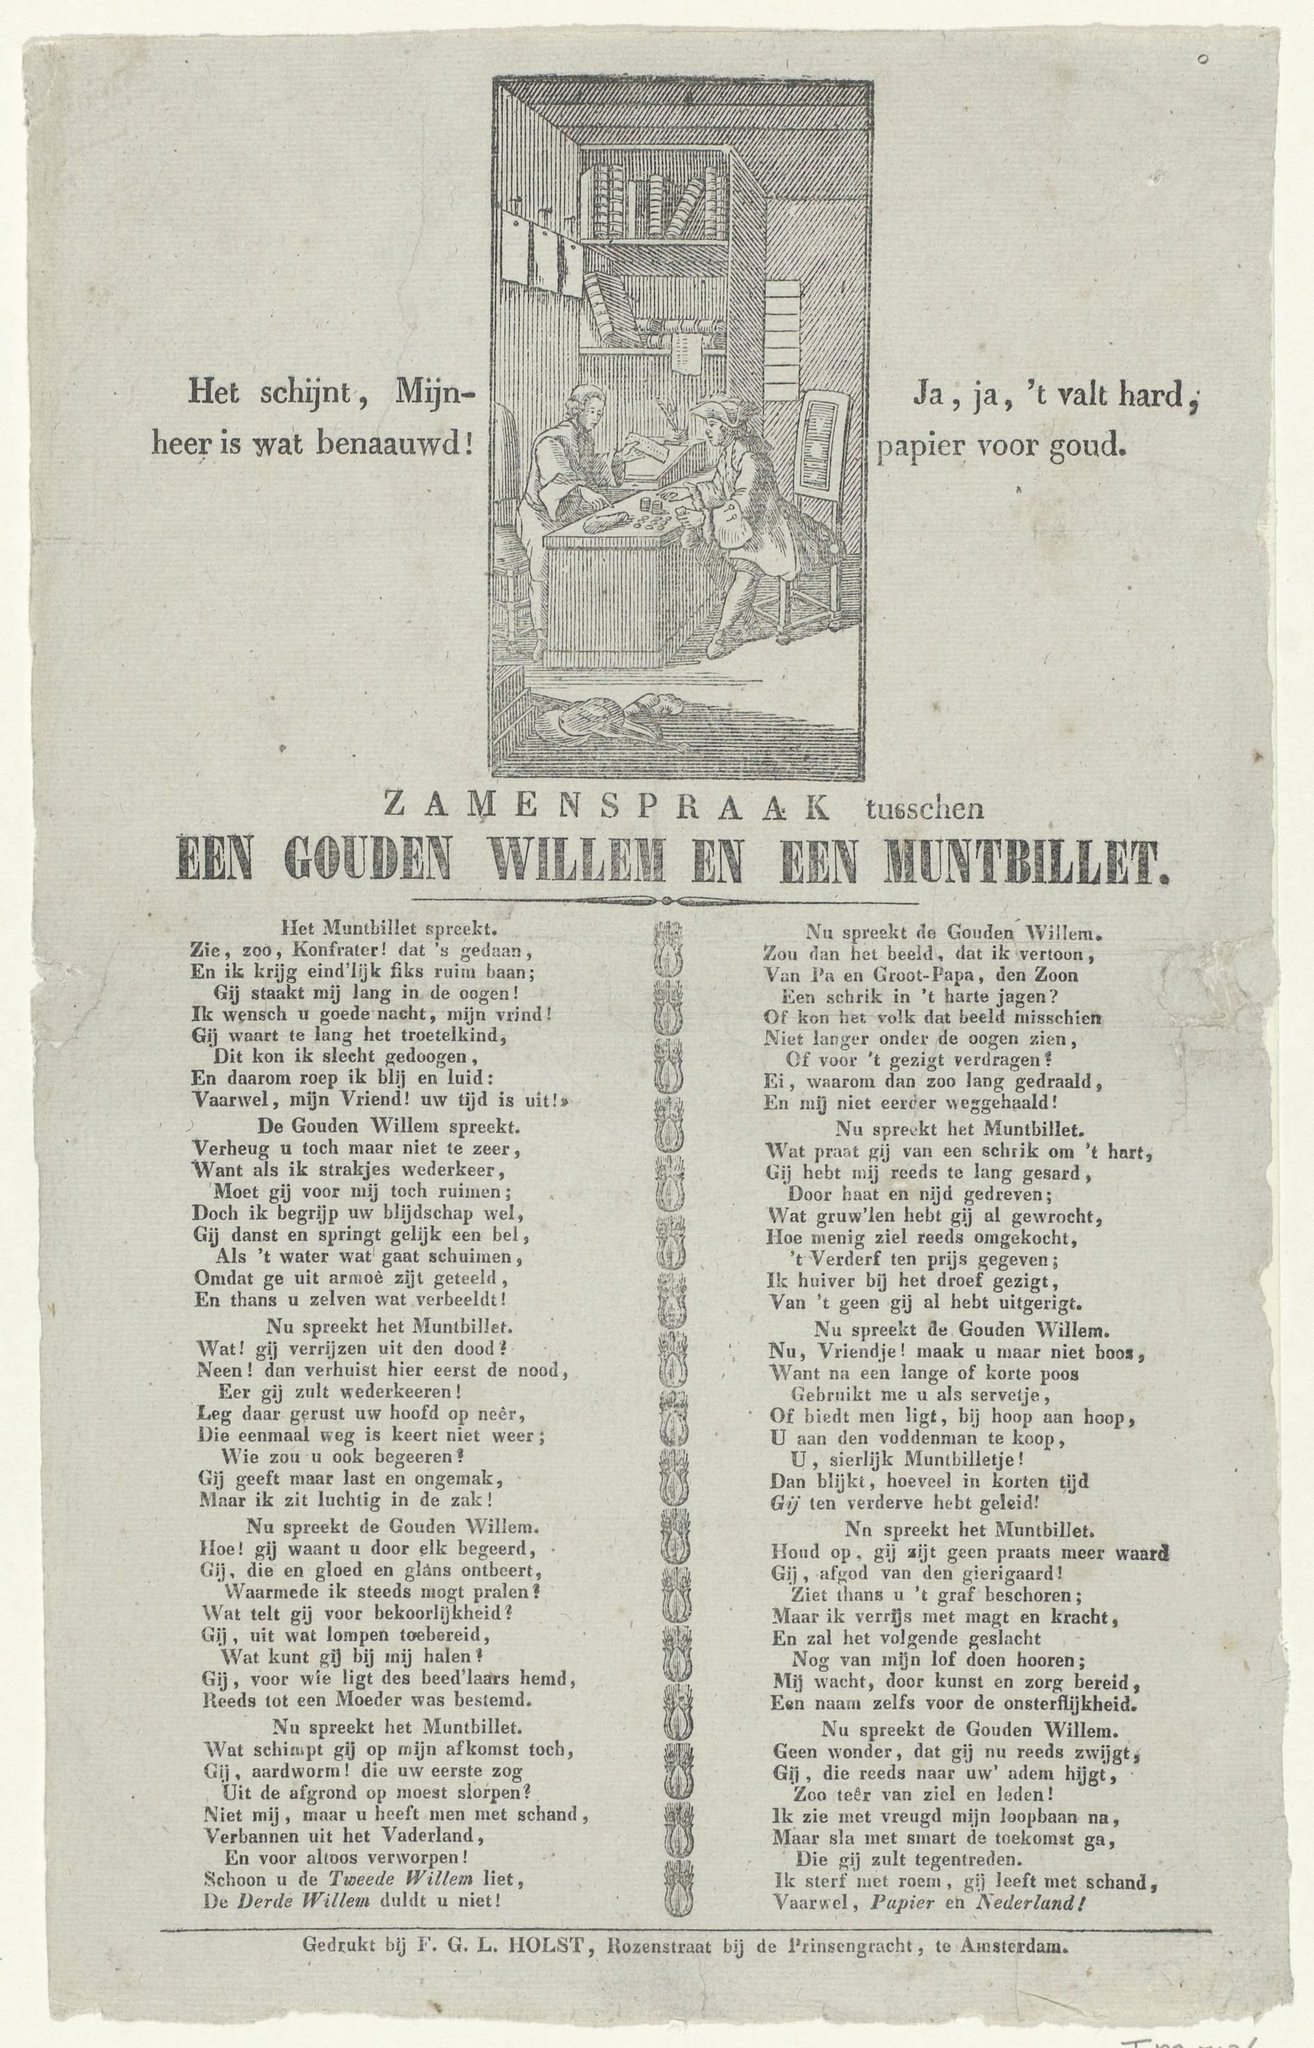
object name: print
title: Zamenspraak tusschen een Gouden Willem en een Muntbillet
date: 1847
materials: paper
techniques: letterpress printing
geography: netherlands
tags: money-changer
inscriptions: collector's mark: Lugt 2228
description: Samenspraak tussen een 'gouden willem' en een 'muntbillet'. Naar aanleiding van de vervanging van de gouden tientjes (tienguldenstuk) door een bankbiljet, bij de Muntwet van 26 november 1847. Vers in twee kolommen onder een afbeelding van een geldwisselaar in zijn kantoor met een klant.